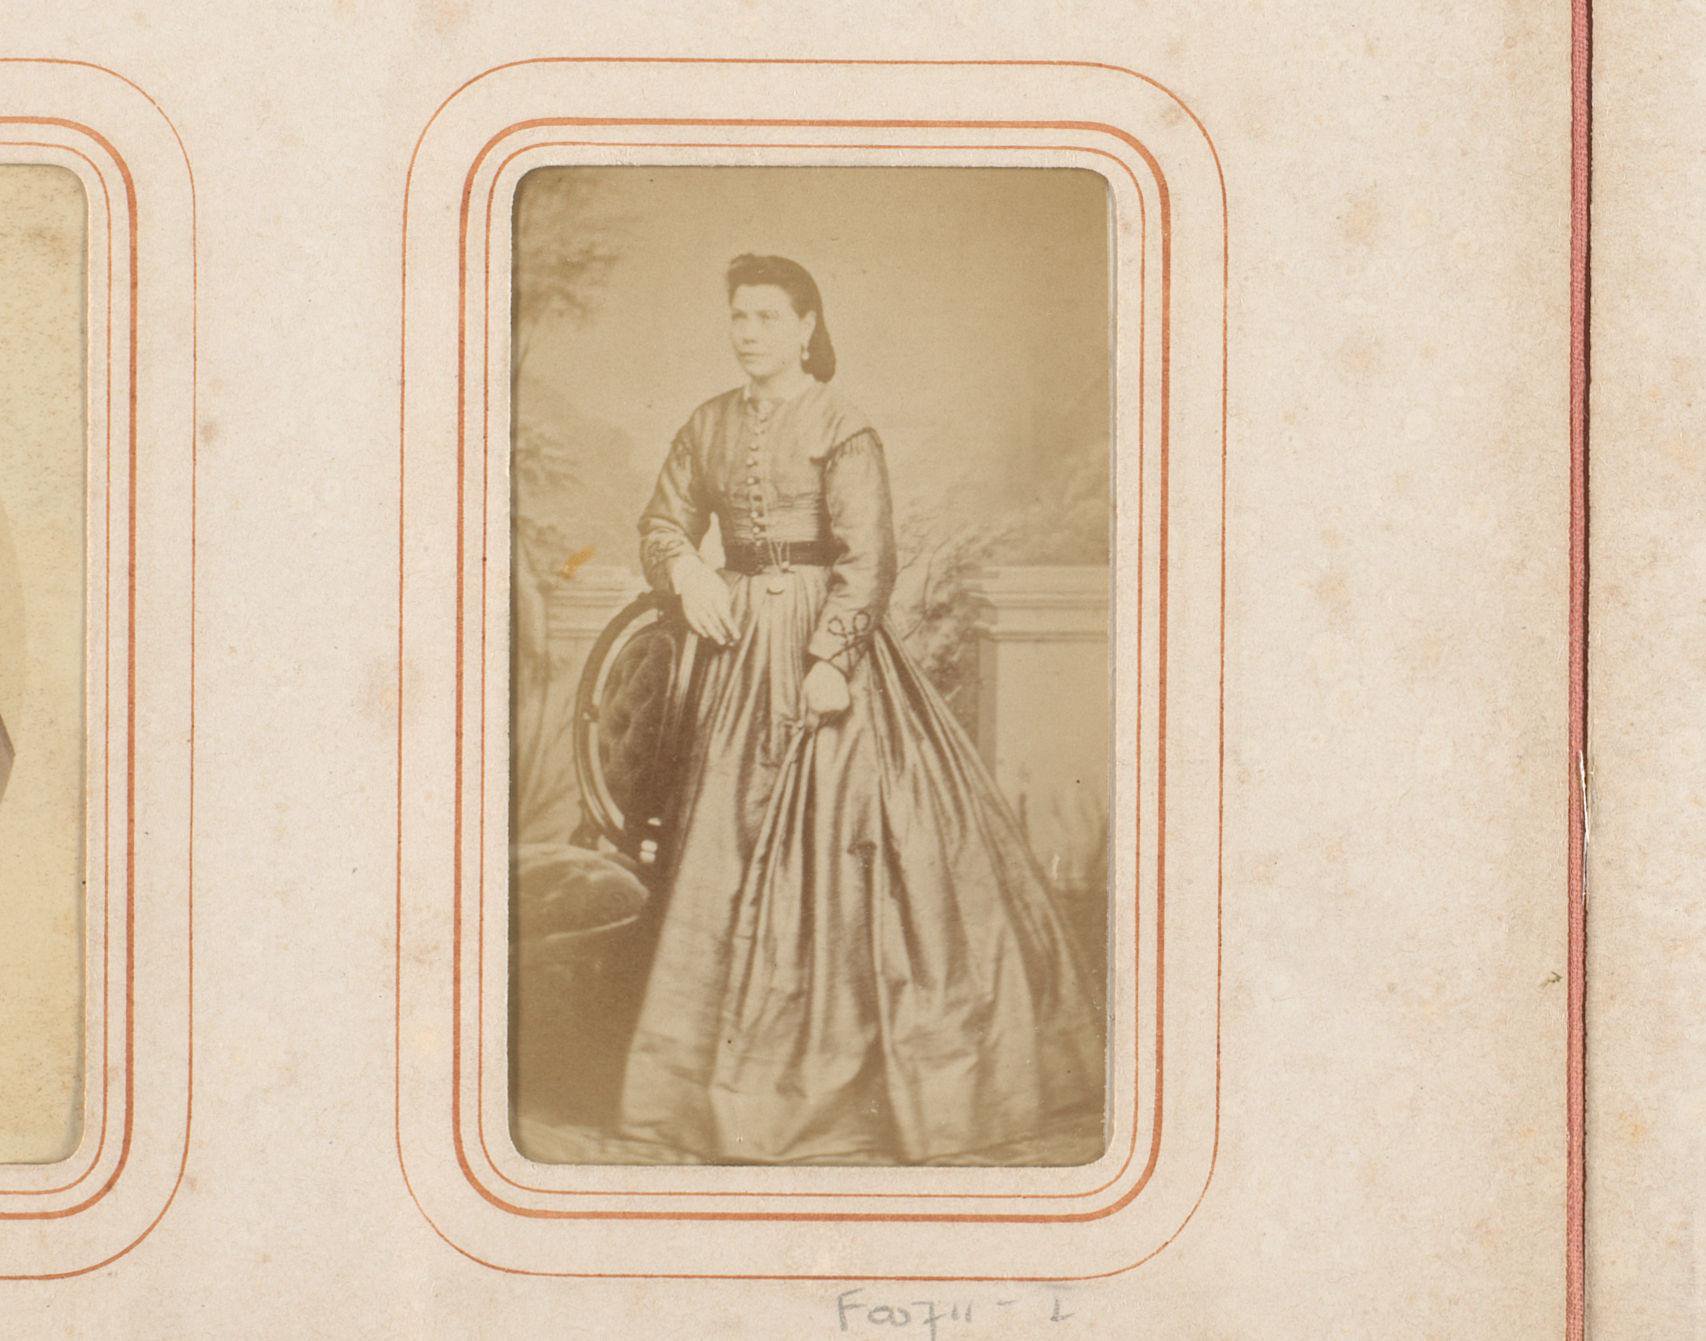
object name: carte de visite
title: Portret van een staande vrouw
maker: Anonymous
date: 1855-1880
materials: cardboard, photographic support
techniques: albumen print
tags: historical persons - bb - woman